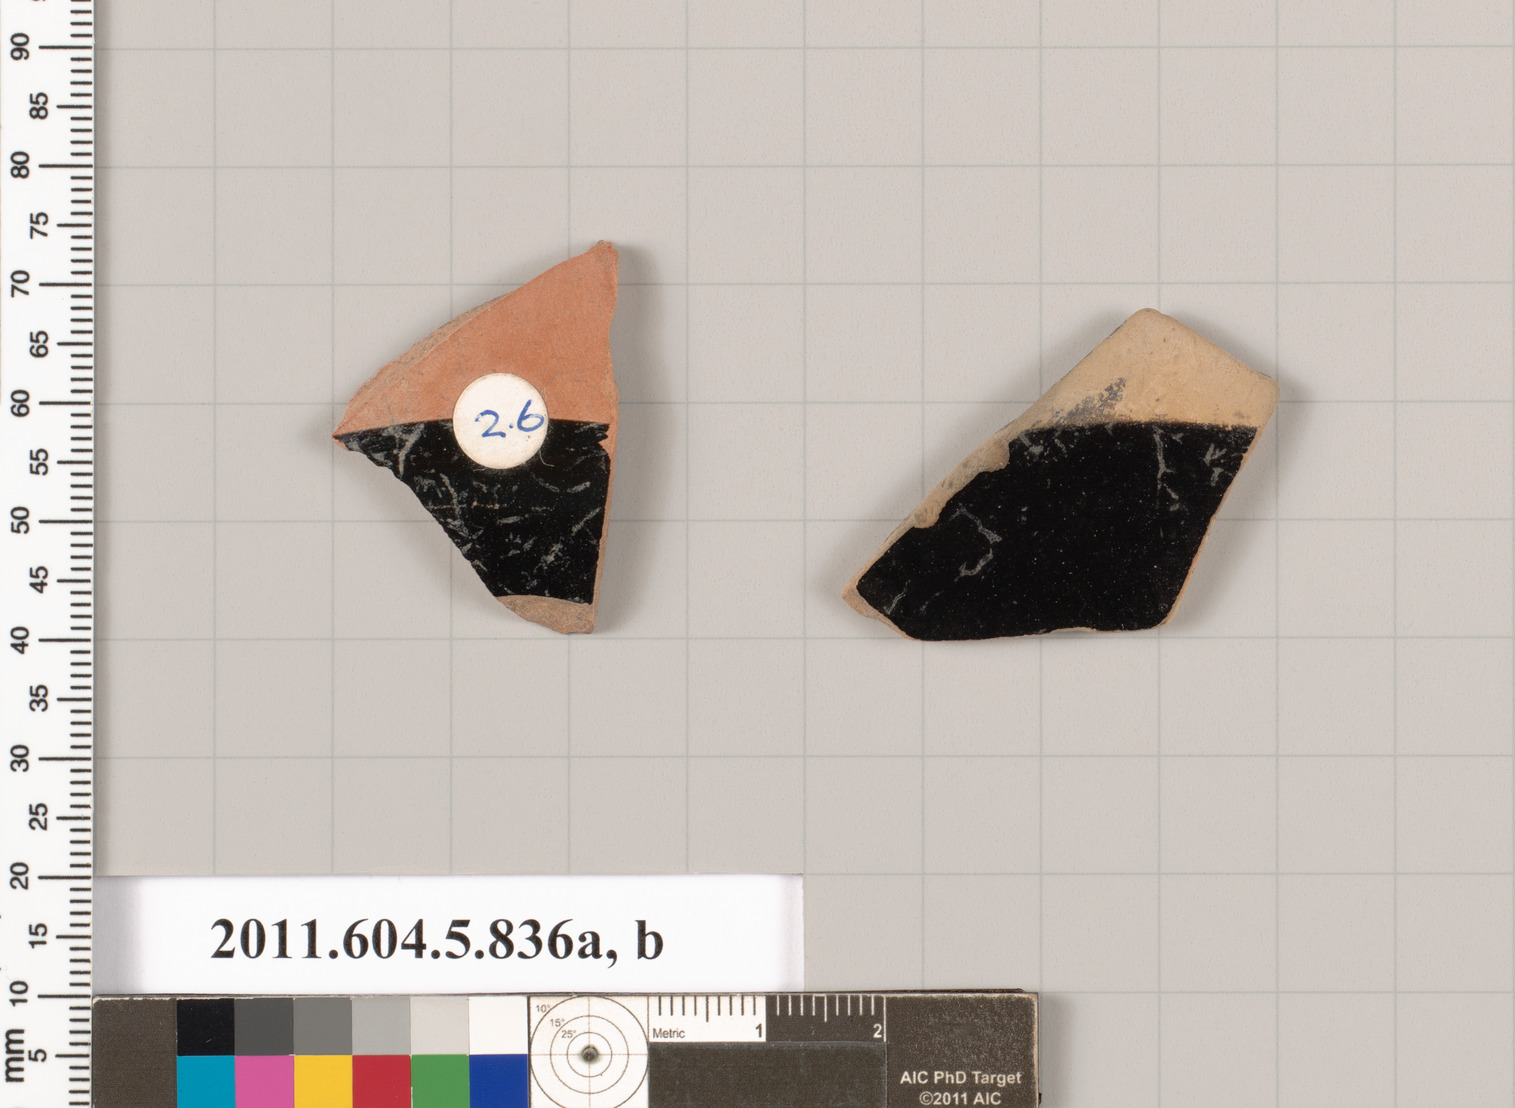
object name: kylix fragment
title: Terracotta fragments of kylikes (drinking cups)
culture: greek, attic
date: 600-401 BCE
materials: terracotta